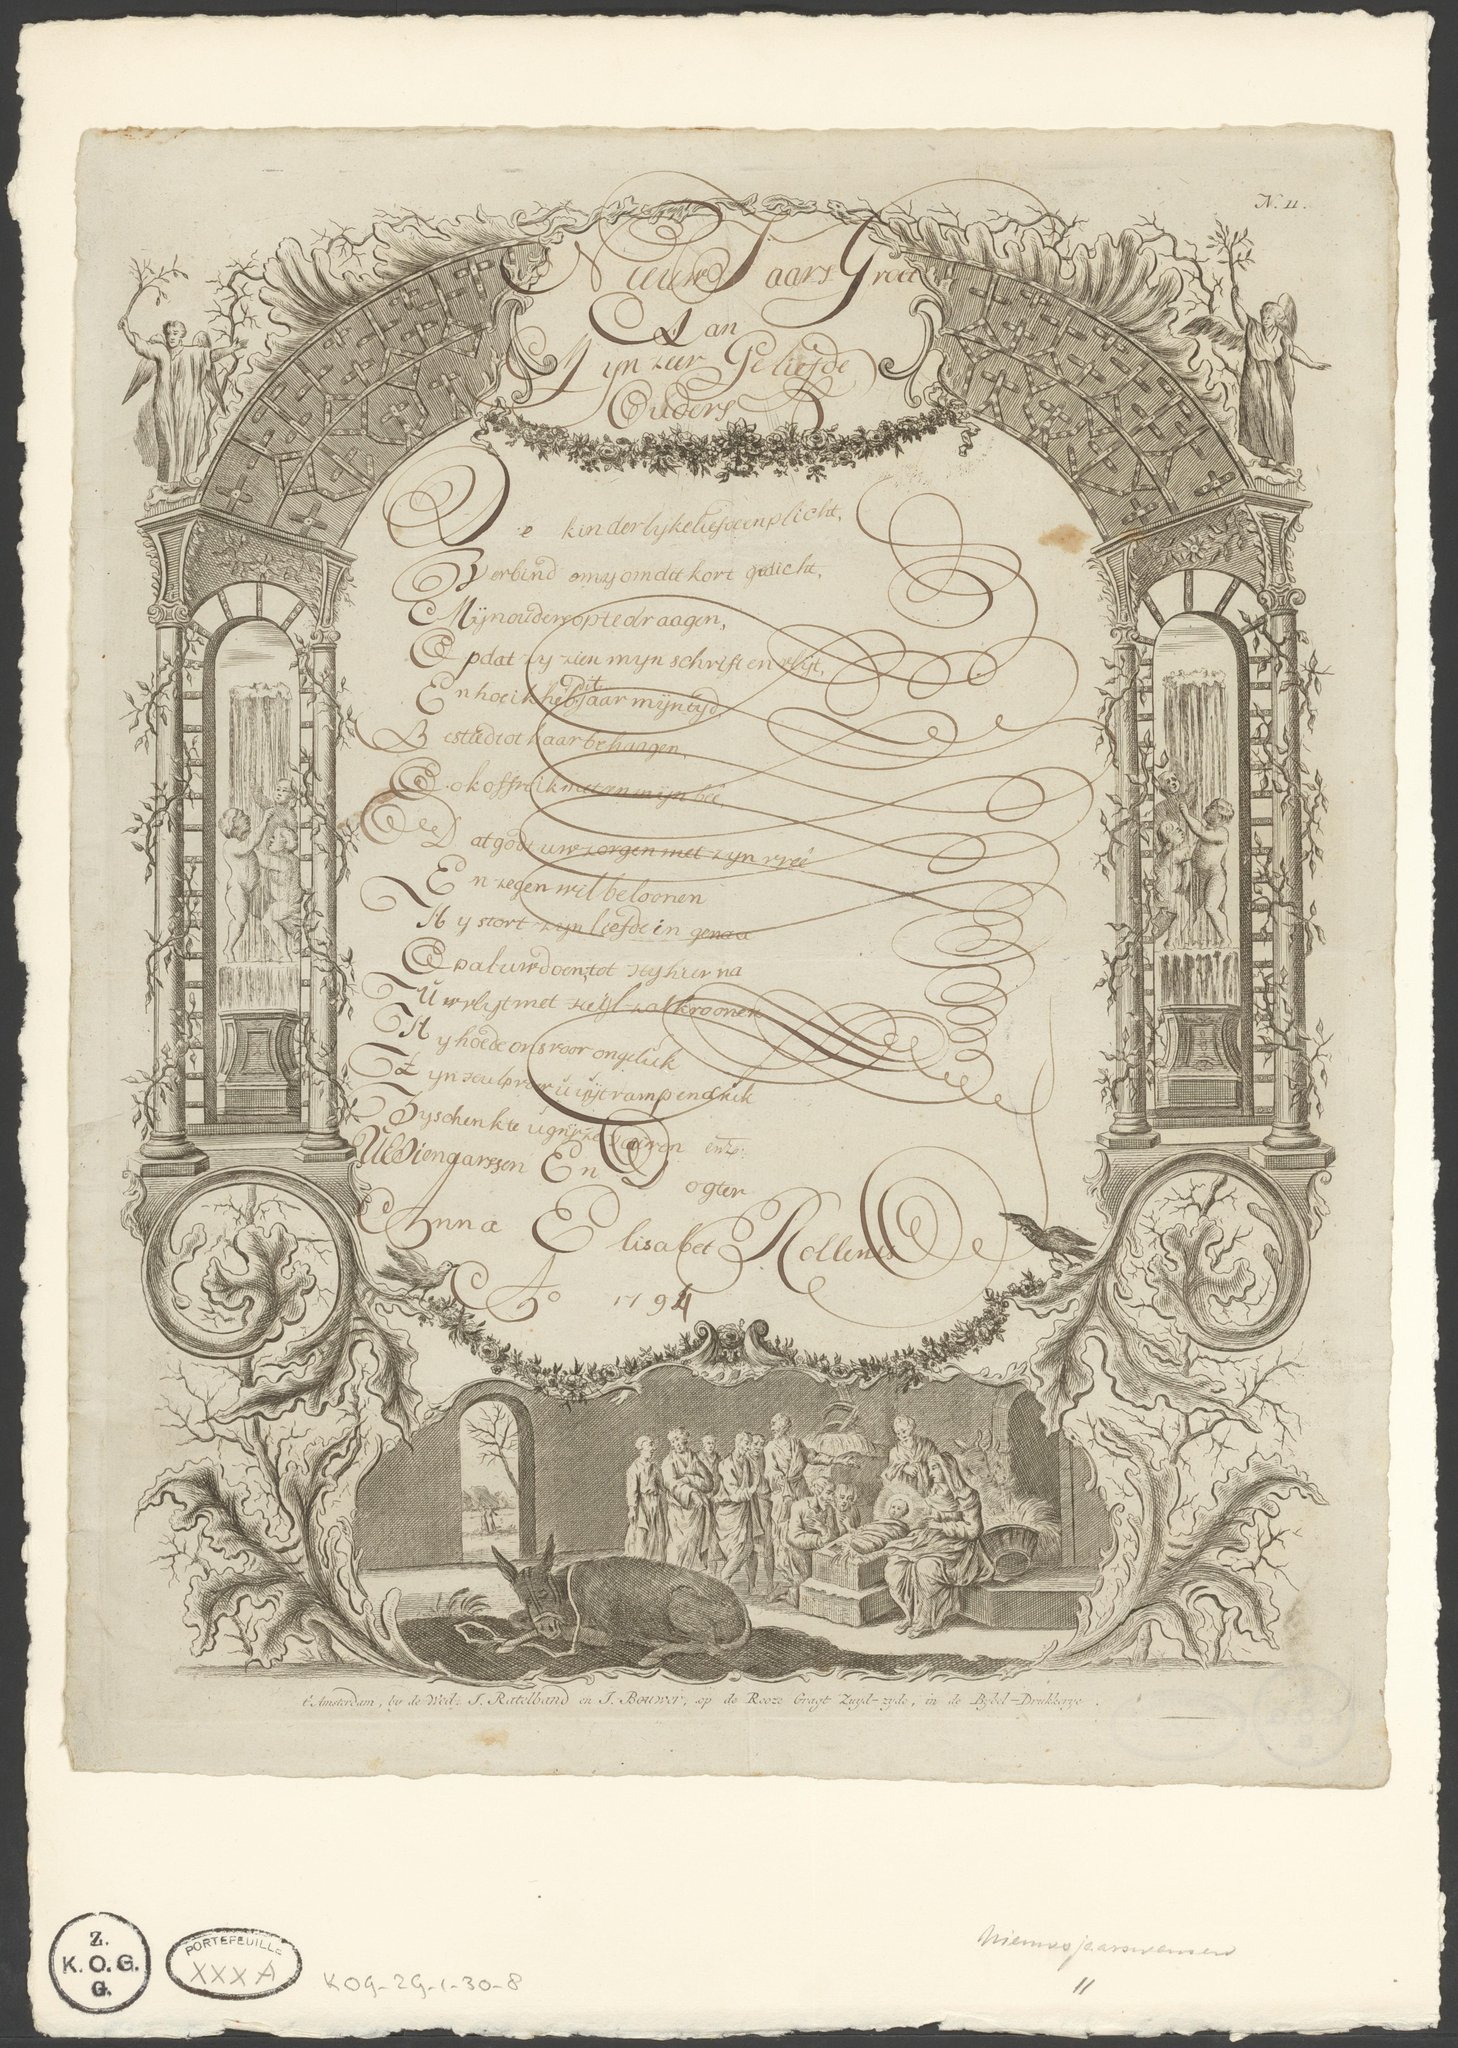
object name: wensbrief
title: Nieuwjaarswens van Anna Elisabet Mollerus, 1794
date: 1794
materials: ink, paper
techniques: engraving, etching, writing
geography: netherlands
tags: january 1 (~ festivities), birth and youth of christ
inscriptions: collector's mark: Lugt 1641, collector's mark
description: Nieuwjaarswens van Anna Elisabet Mollerus, 1794. Gericht aan haar ouders. Handgeschreven vers binnen een voorgedrukte omlijsting met ornamenten en een voorstelling van de geboorte van Christus. Rechtsboven genummerd: N. 11. Onderwerpsrubrieken binnen de Atlas Zeden en Gewoonten: Nieuwjaars- en kermiswenschen.